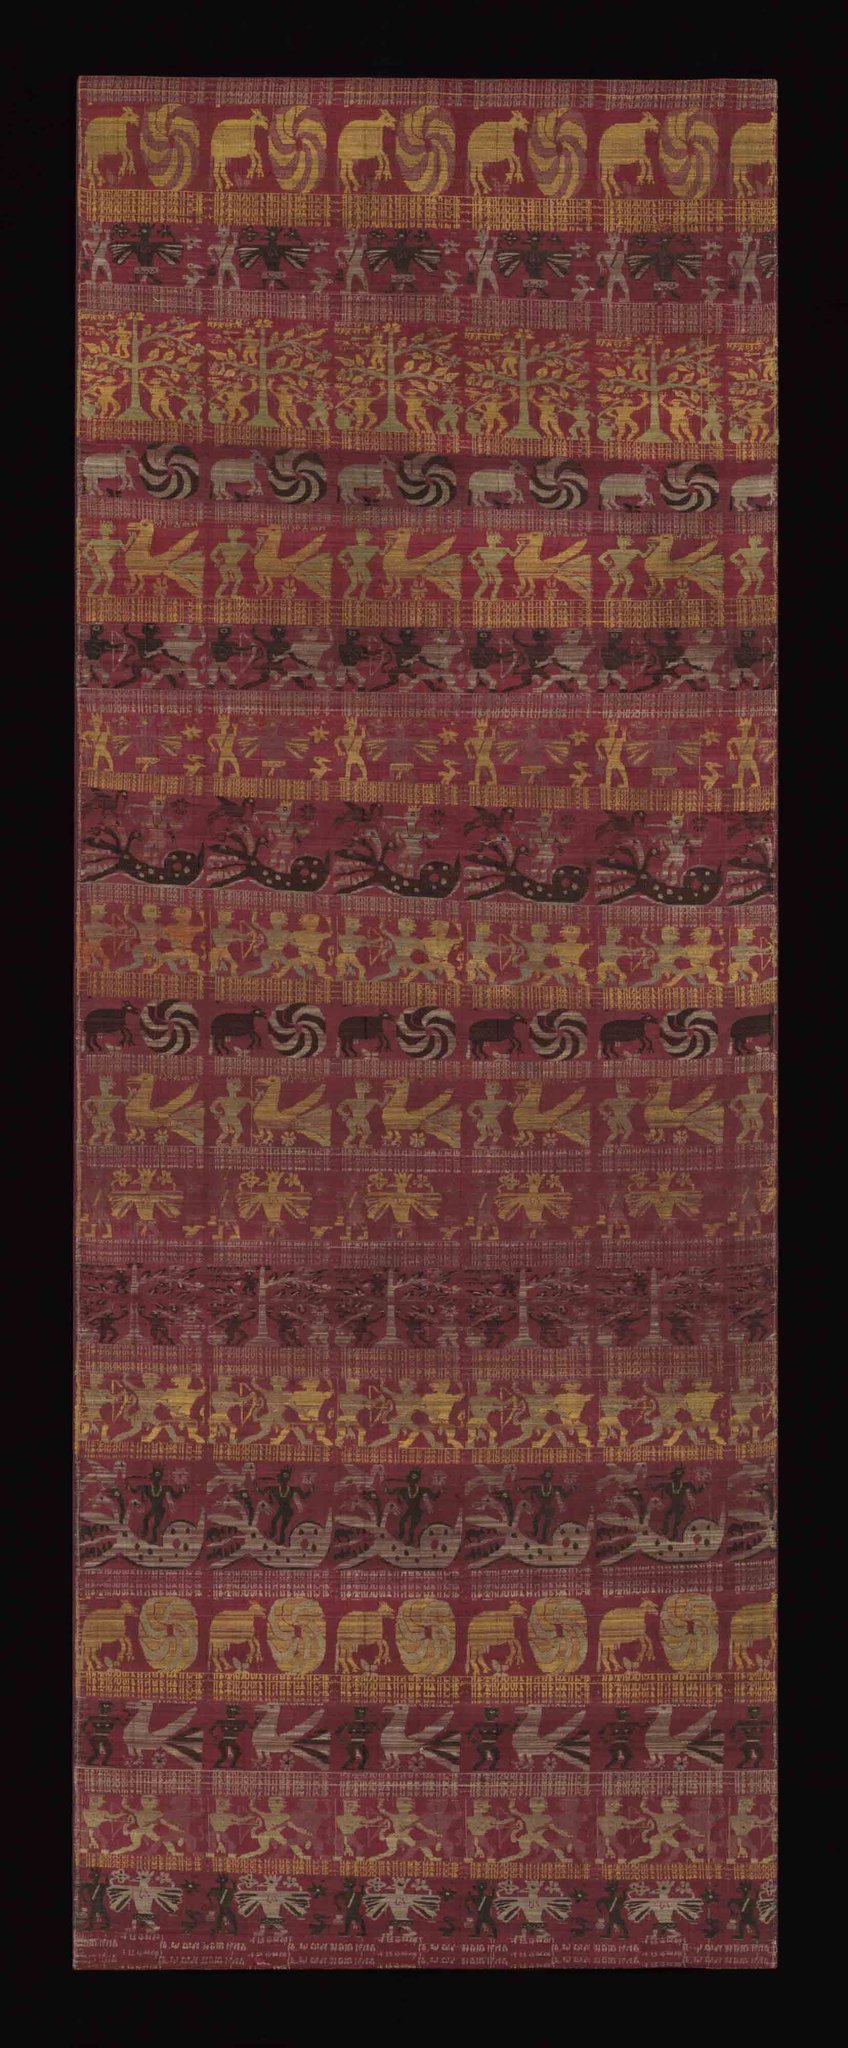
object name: hanging, temple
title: Temple Hanging with Scenes from the Bhagavata Purana and the Ramayana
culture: indian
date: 1601-1633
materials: silk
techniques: lampas